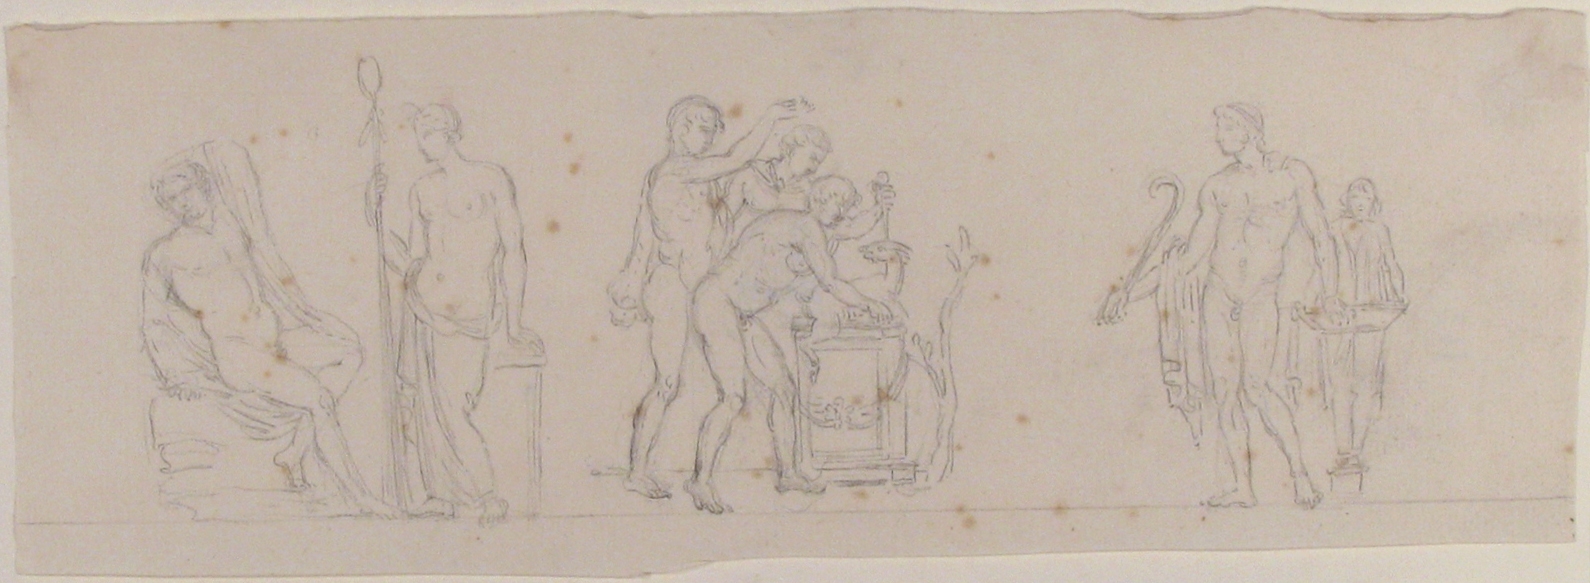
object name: drawing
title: Sacrifice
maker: anonymous, french, 18th century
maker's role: artist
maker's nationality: french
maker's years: 1700-1800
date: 1701-1800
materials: chalk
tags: animals,male nudes